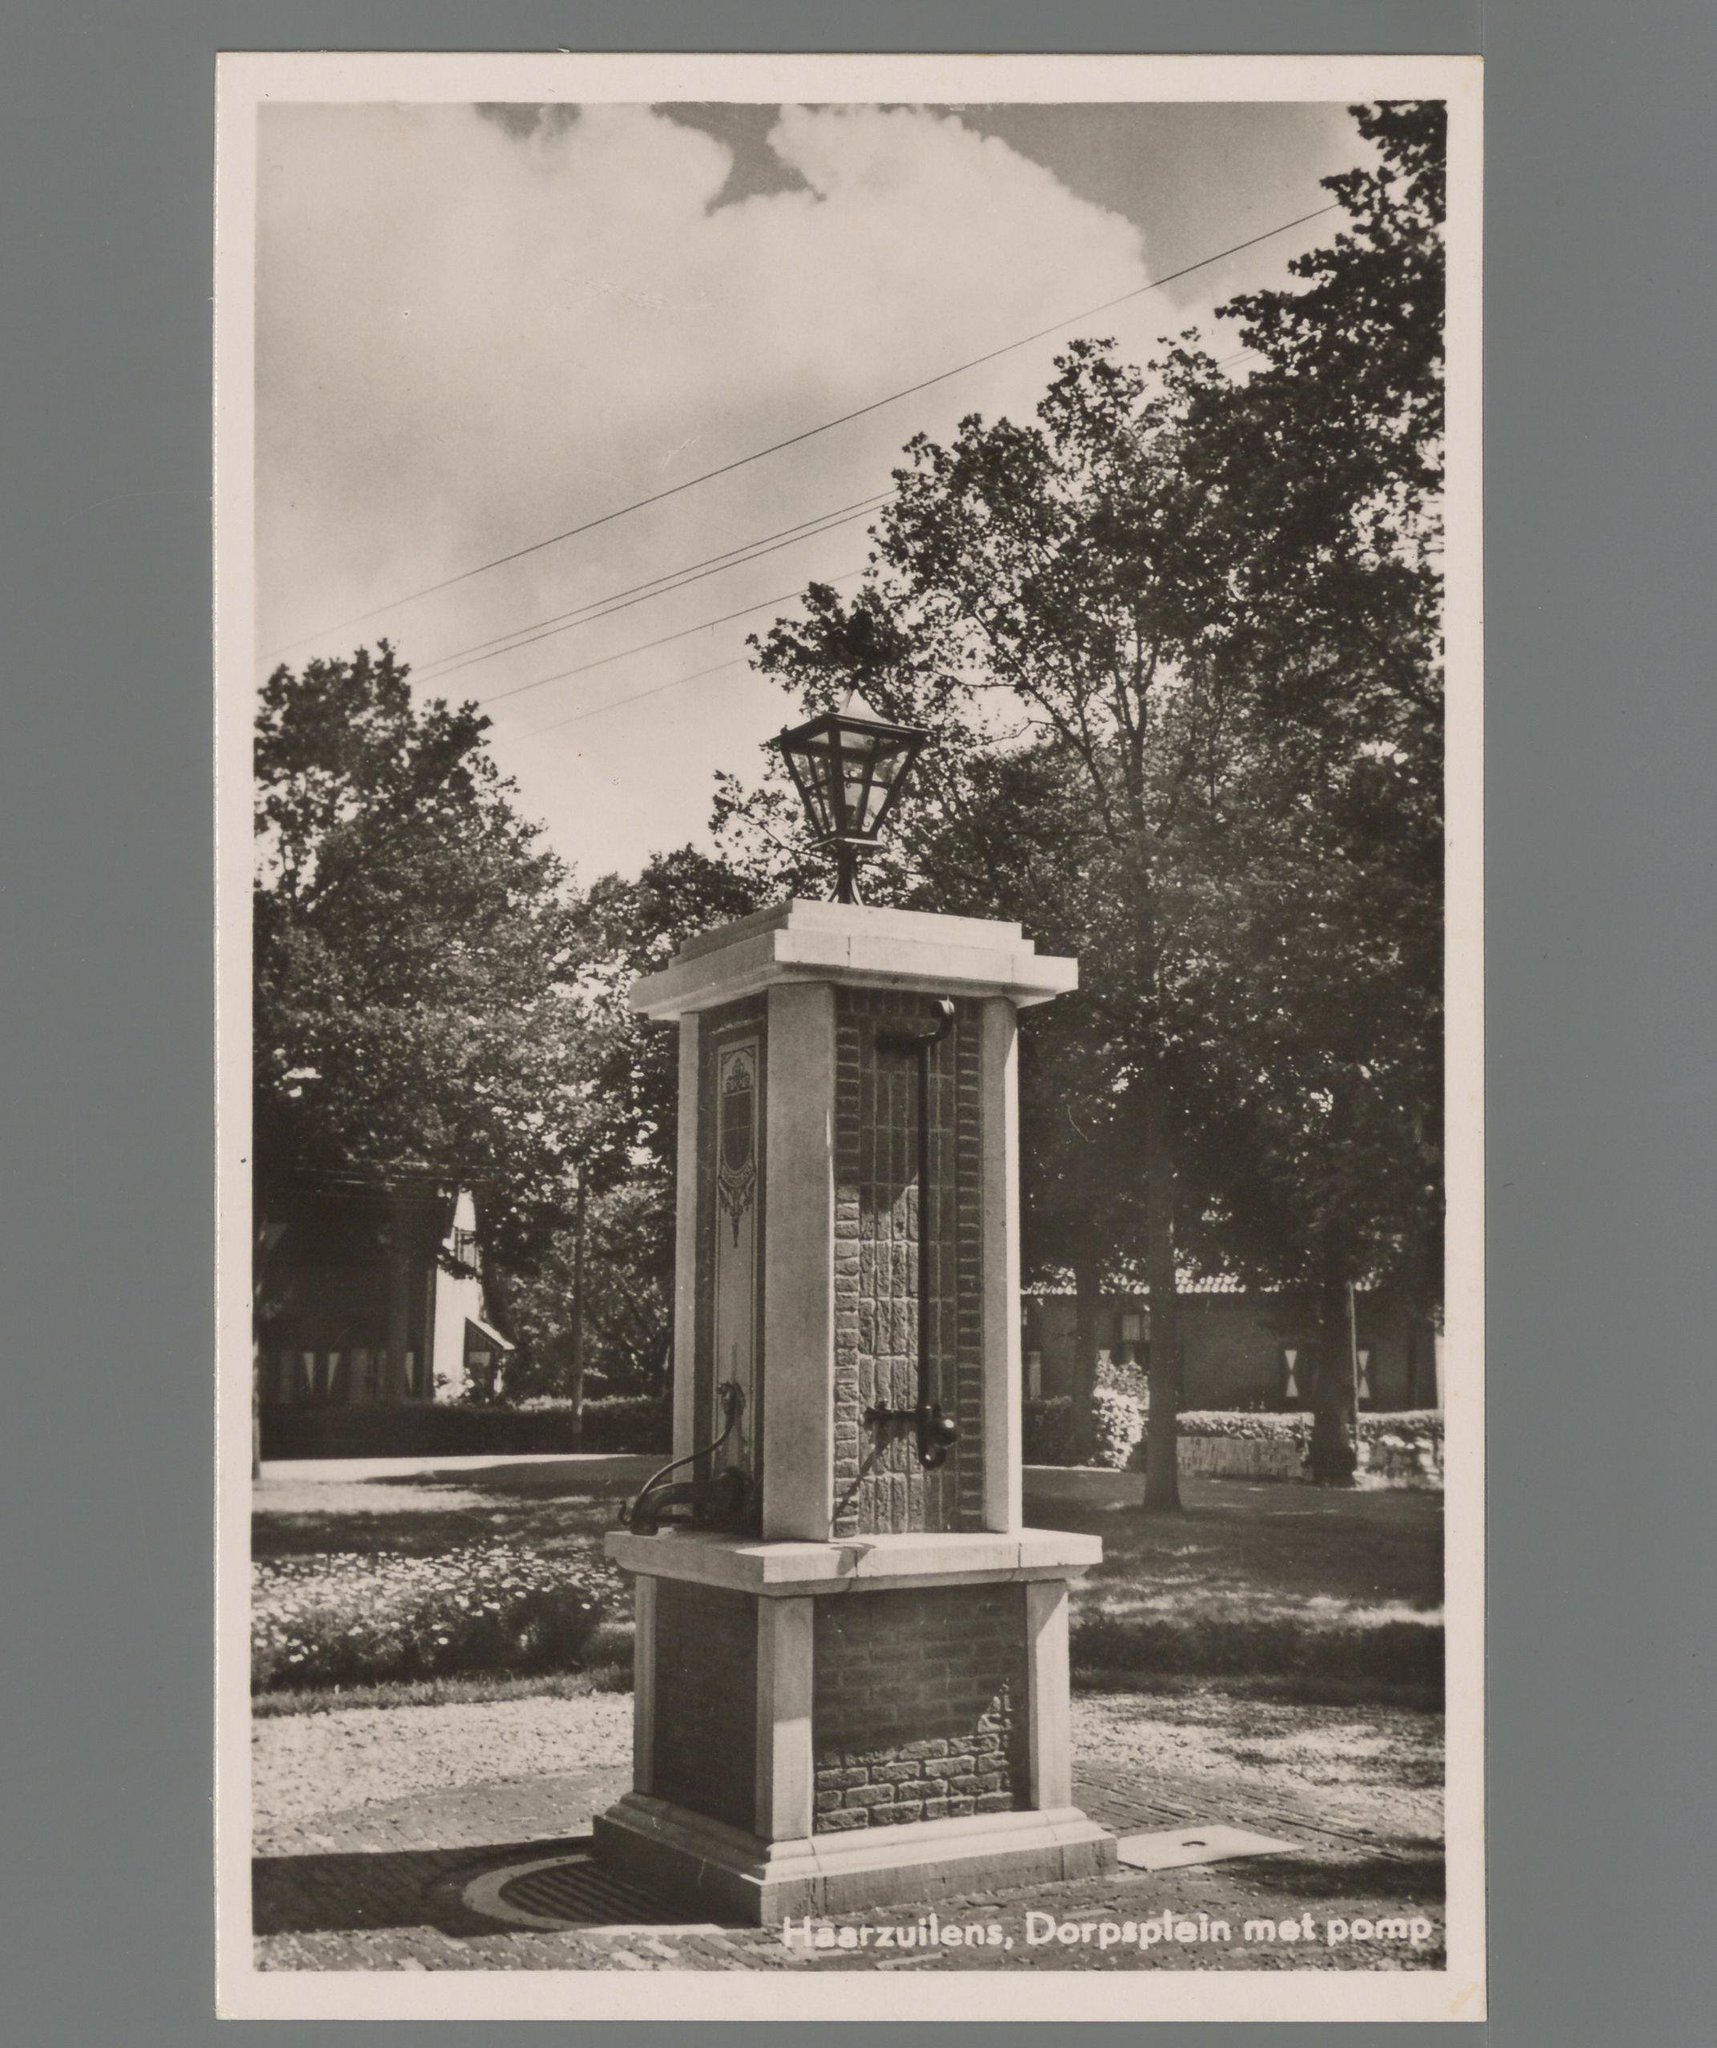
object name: ansichtkaart, prentbriefkaart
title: Haarzuilens, Dorpsplein met pomp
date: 1905-1953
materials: photographic support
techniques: photography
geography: arnhem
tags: utilitarian, public pump or water fountain, village square, place